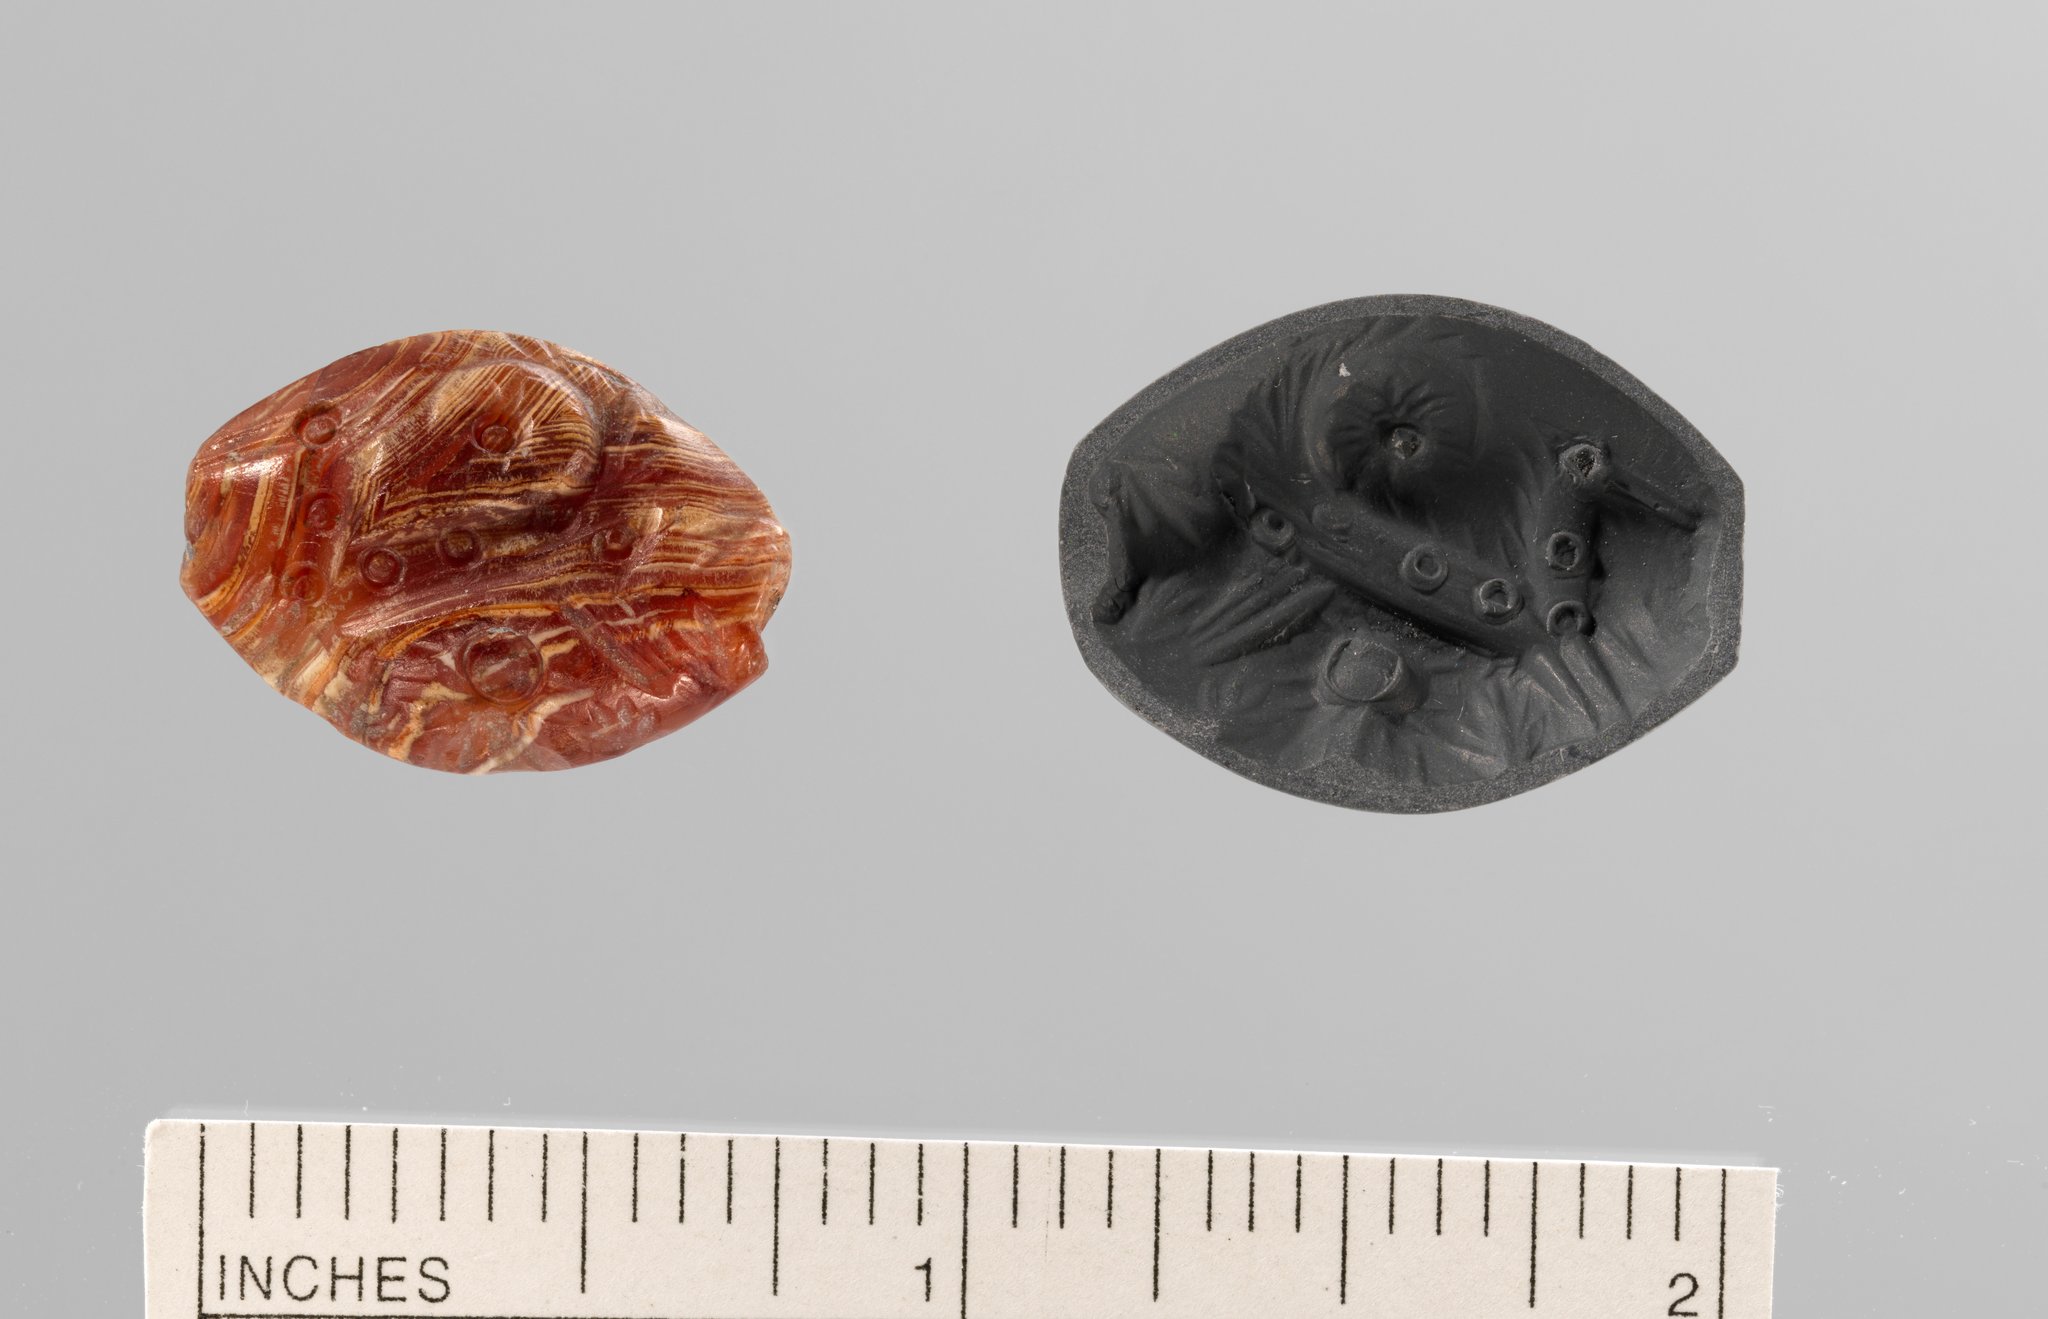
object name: seal, amygdaloid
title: Carnelian Amygdaloid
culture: minoan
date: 1650-1500 BCE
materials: gemstone